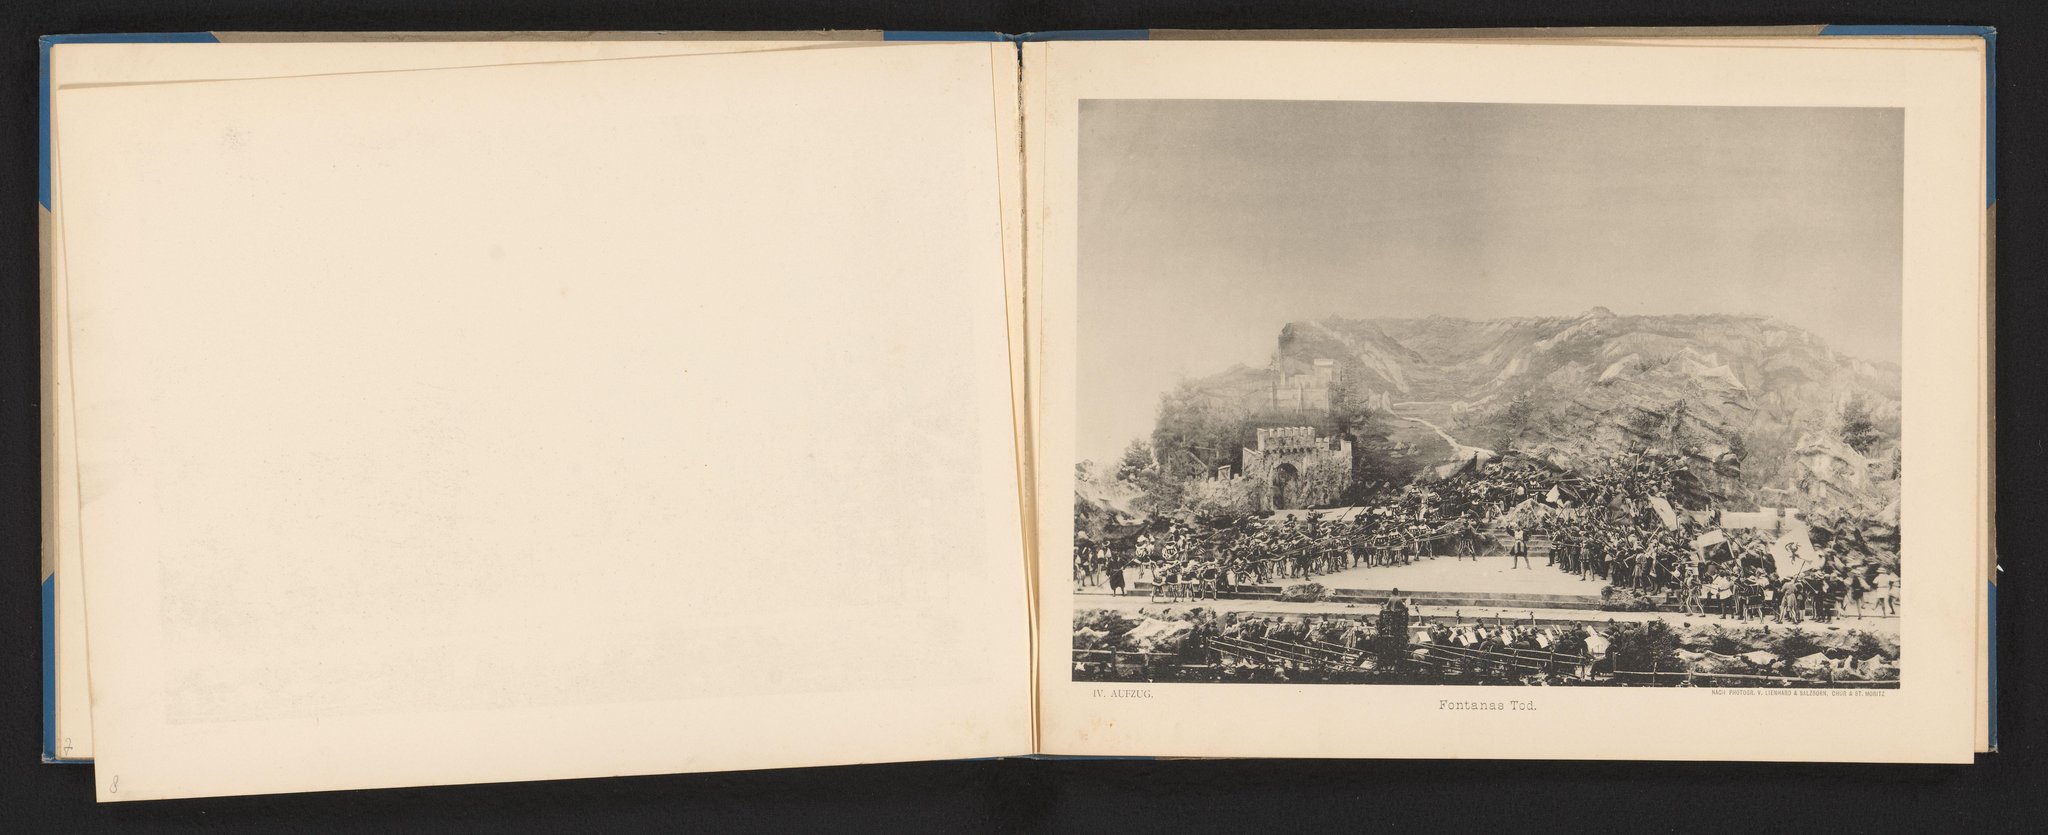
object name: photomechanical print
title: Gezicht op de dood van Benedikt Fontana tijdens de Calven-Feier te Chur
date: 1898-1899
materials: paper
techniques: photograph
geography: chur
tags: group of actors, troupe; actors on the stage, dying, mountains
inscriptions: number: ‘IV.’